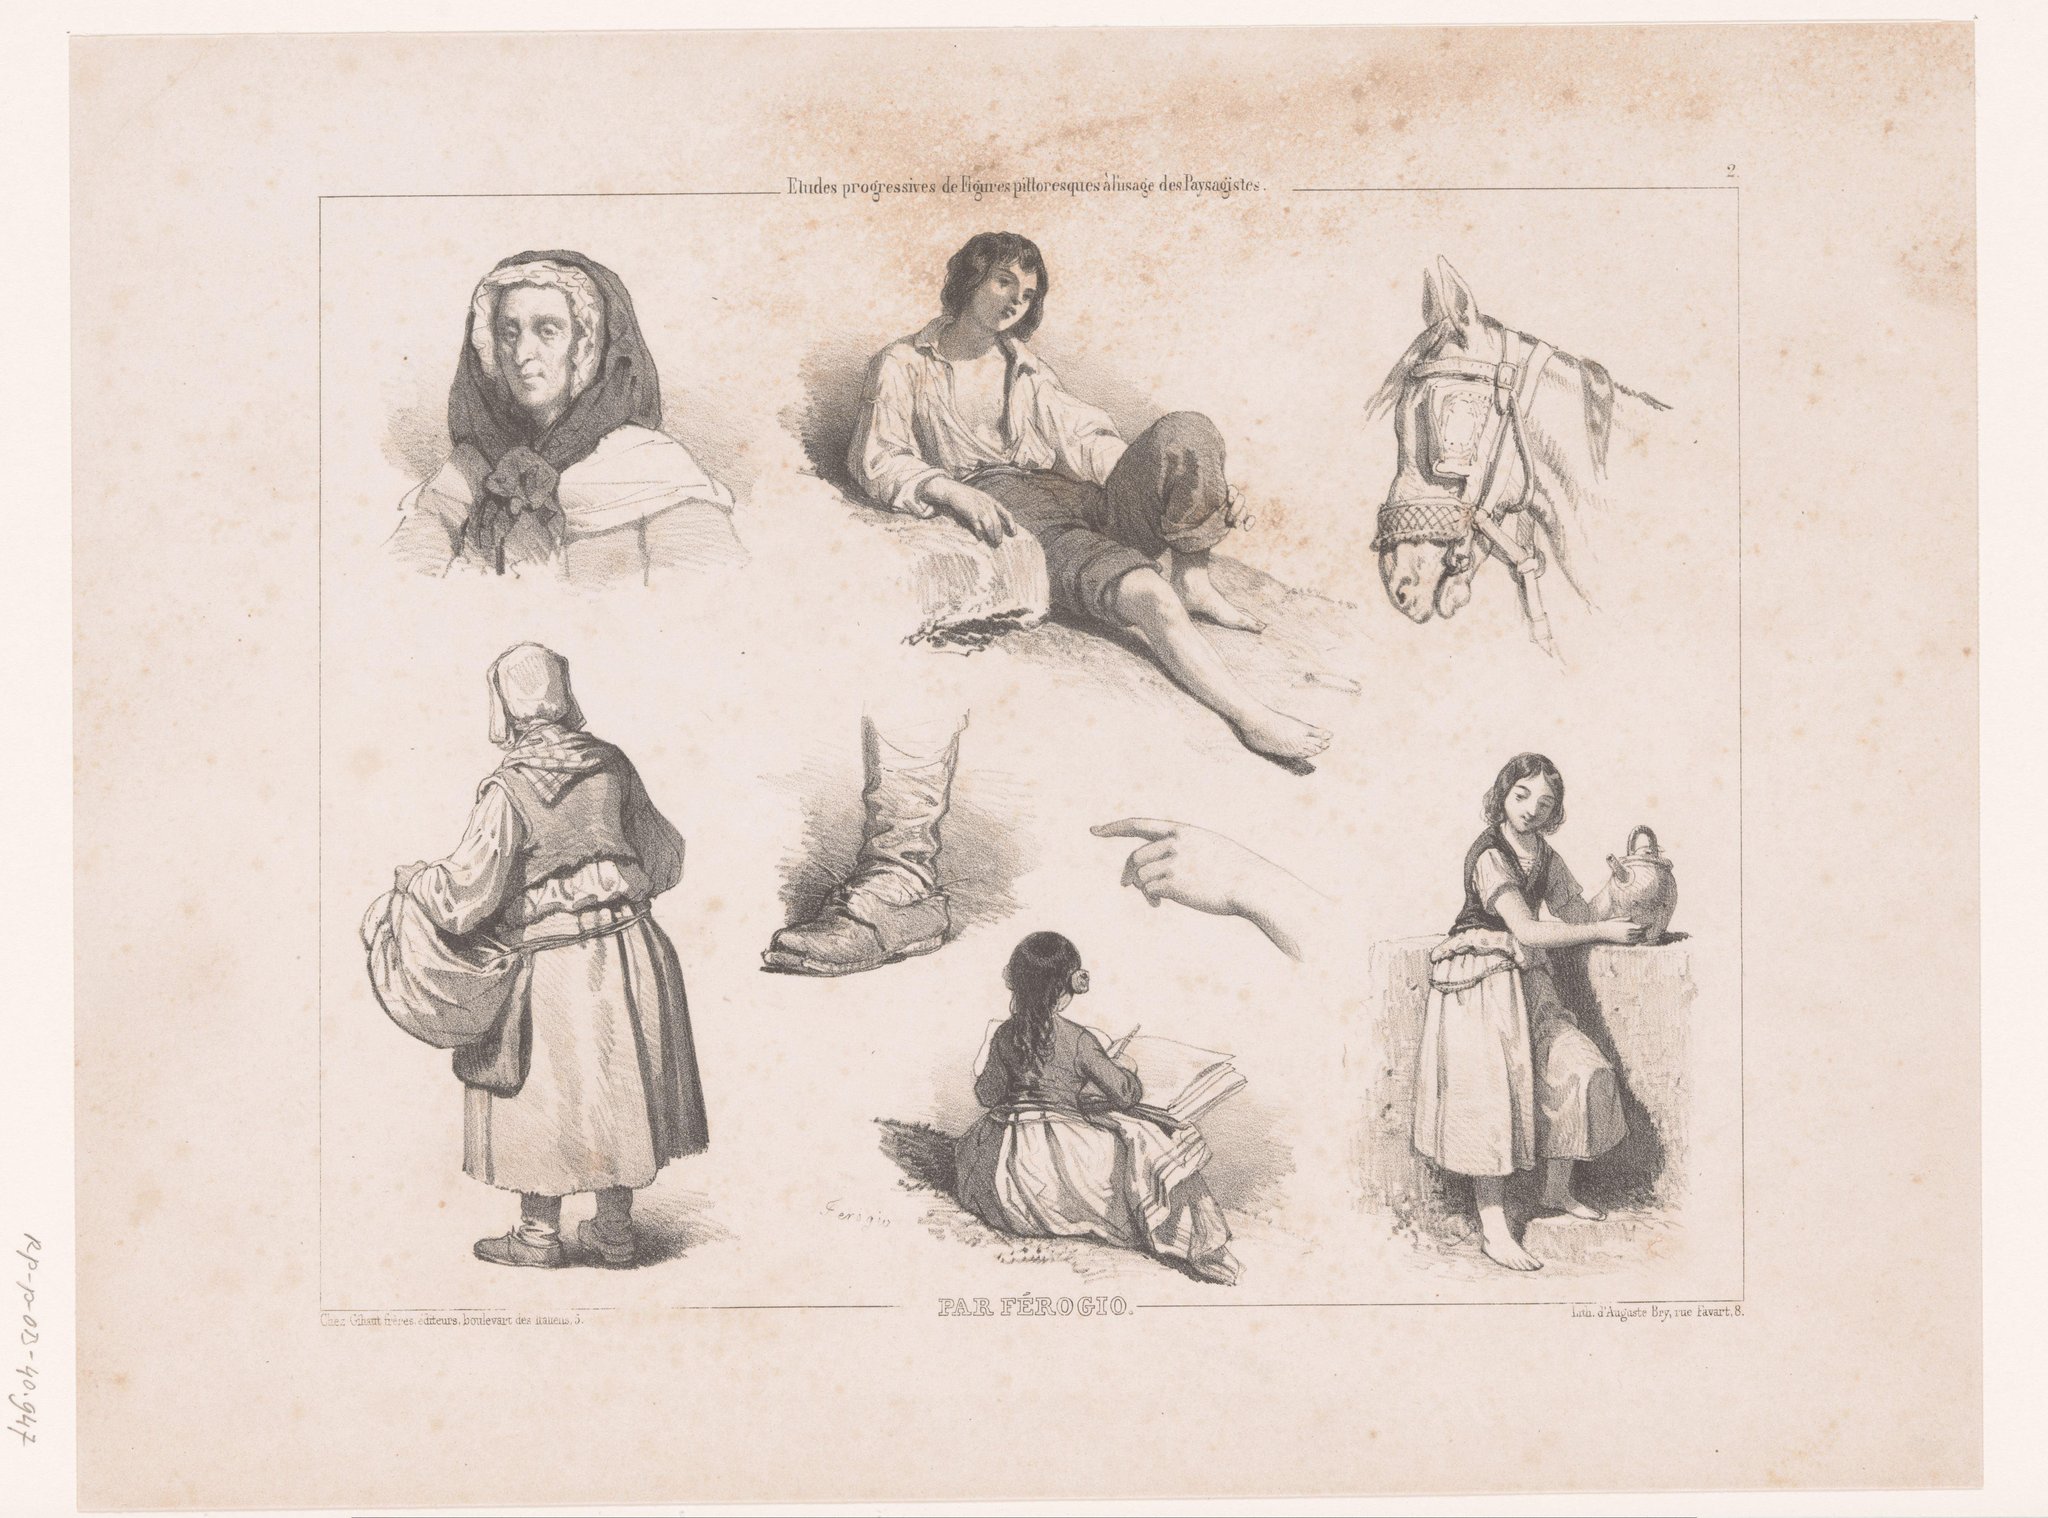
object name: print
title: Voorbeelden van figuurstudies voor landschapskunstenaars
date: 1839-1845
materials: paper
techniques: lithograph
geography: paris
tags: country dwellers, horse